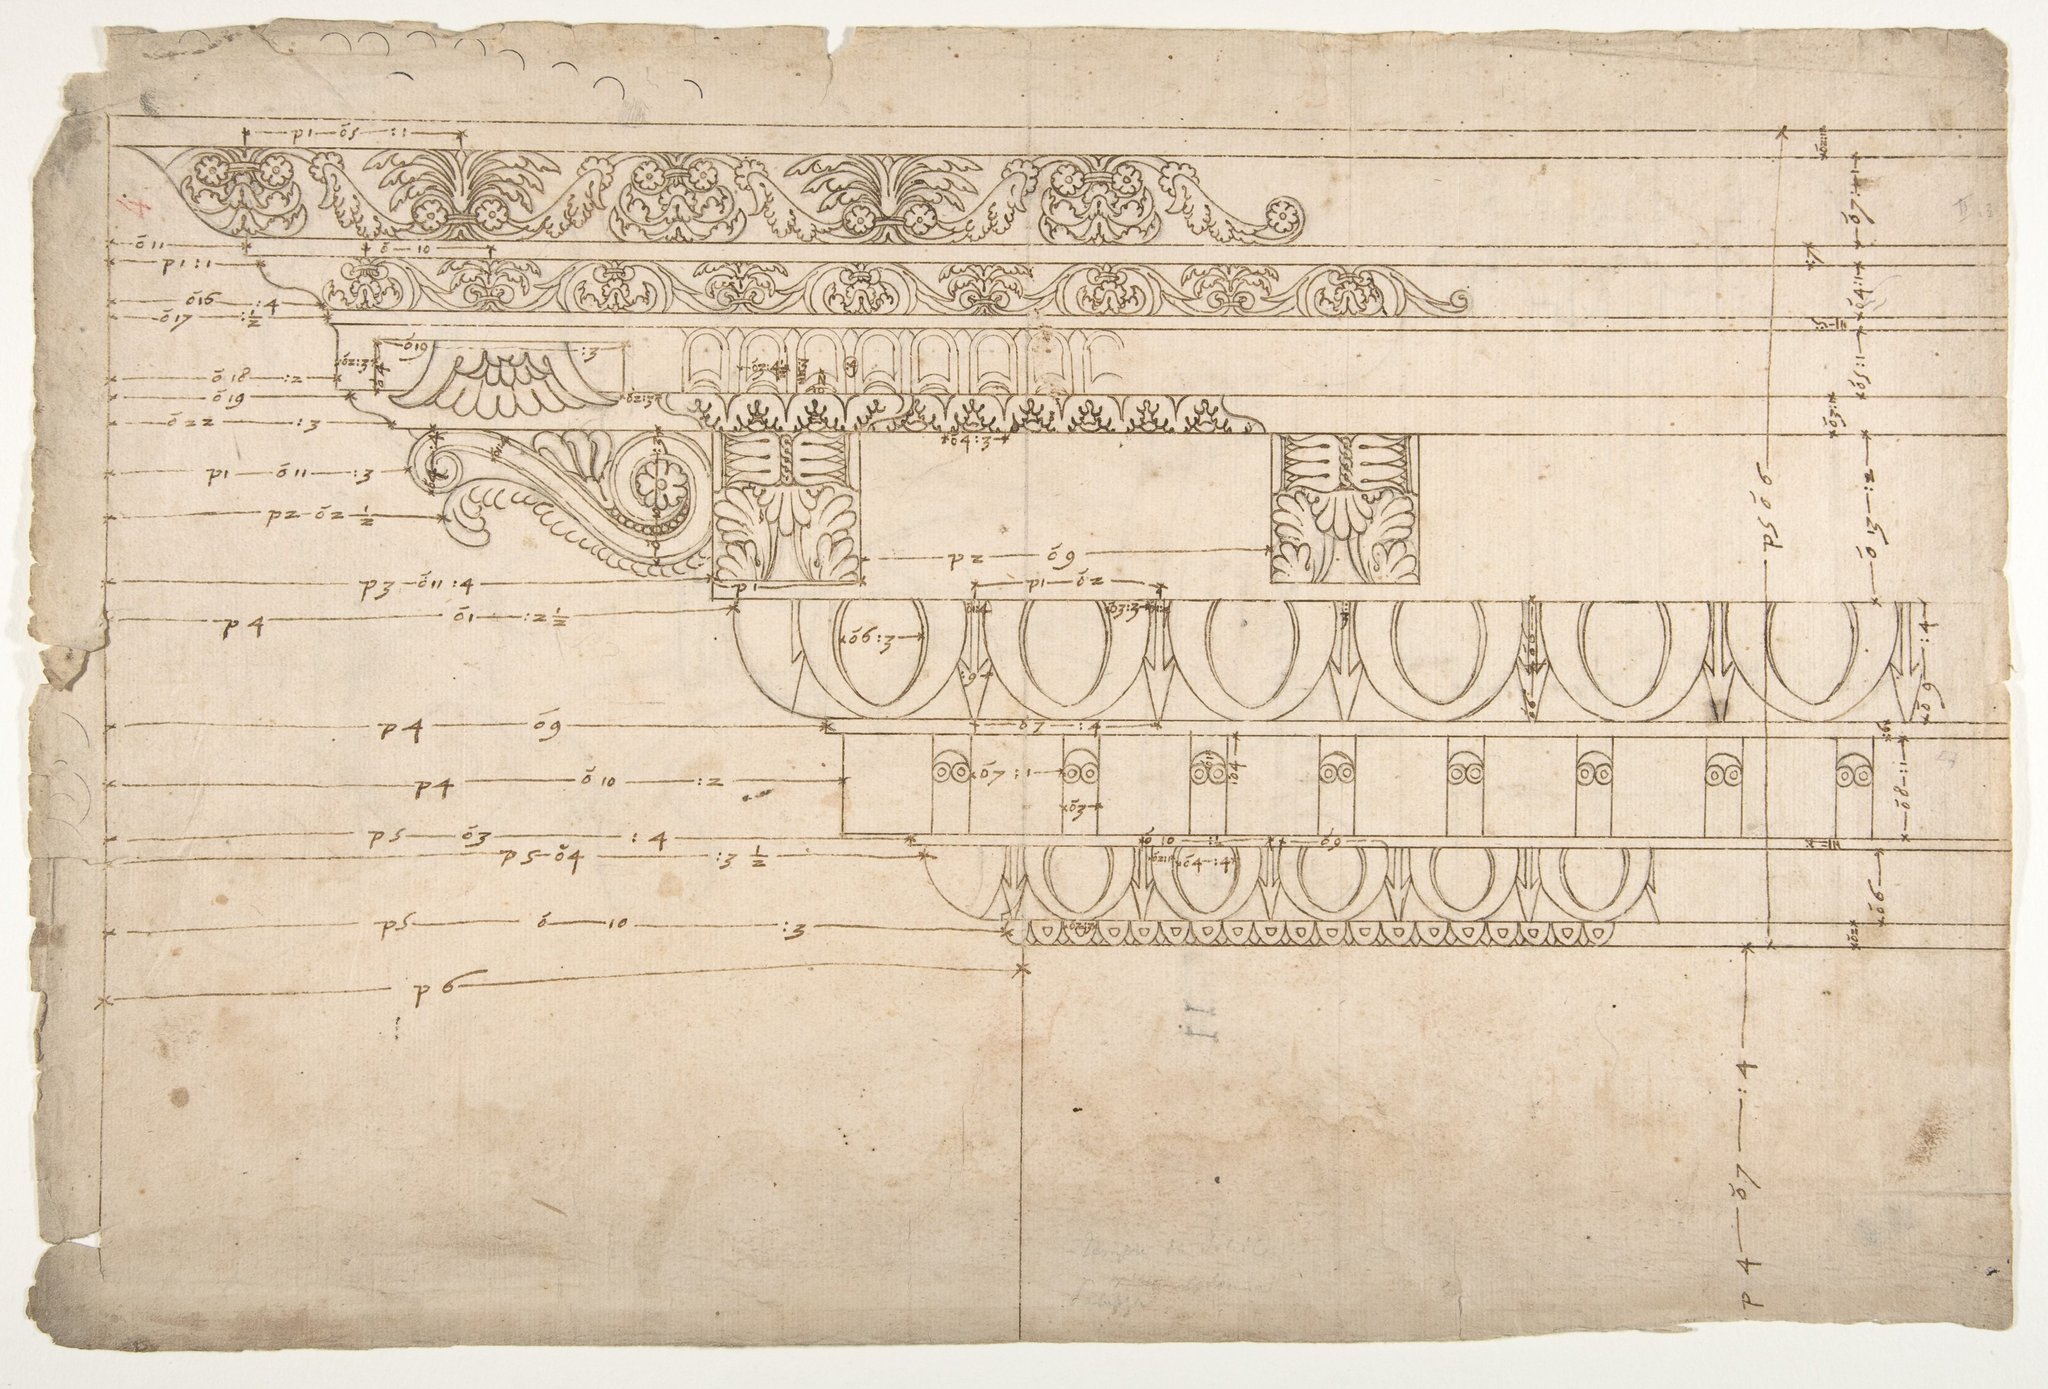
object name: collection ornament architecture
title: Temple of Minerva, elevation of cornice (recto) Temple of Minerva, elevation of capital and base (verso)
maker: anonymous, french, 16th century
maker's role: draftsman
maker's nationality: french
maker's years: 1500-1600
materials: chalk, ink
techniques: incising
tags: architecture,capitals